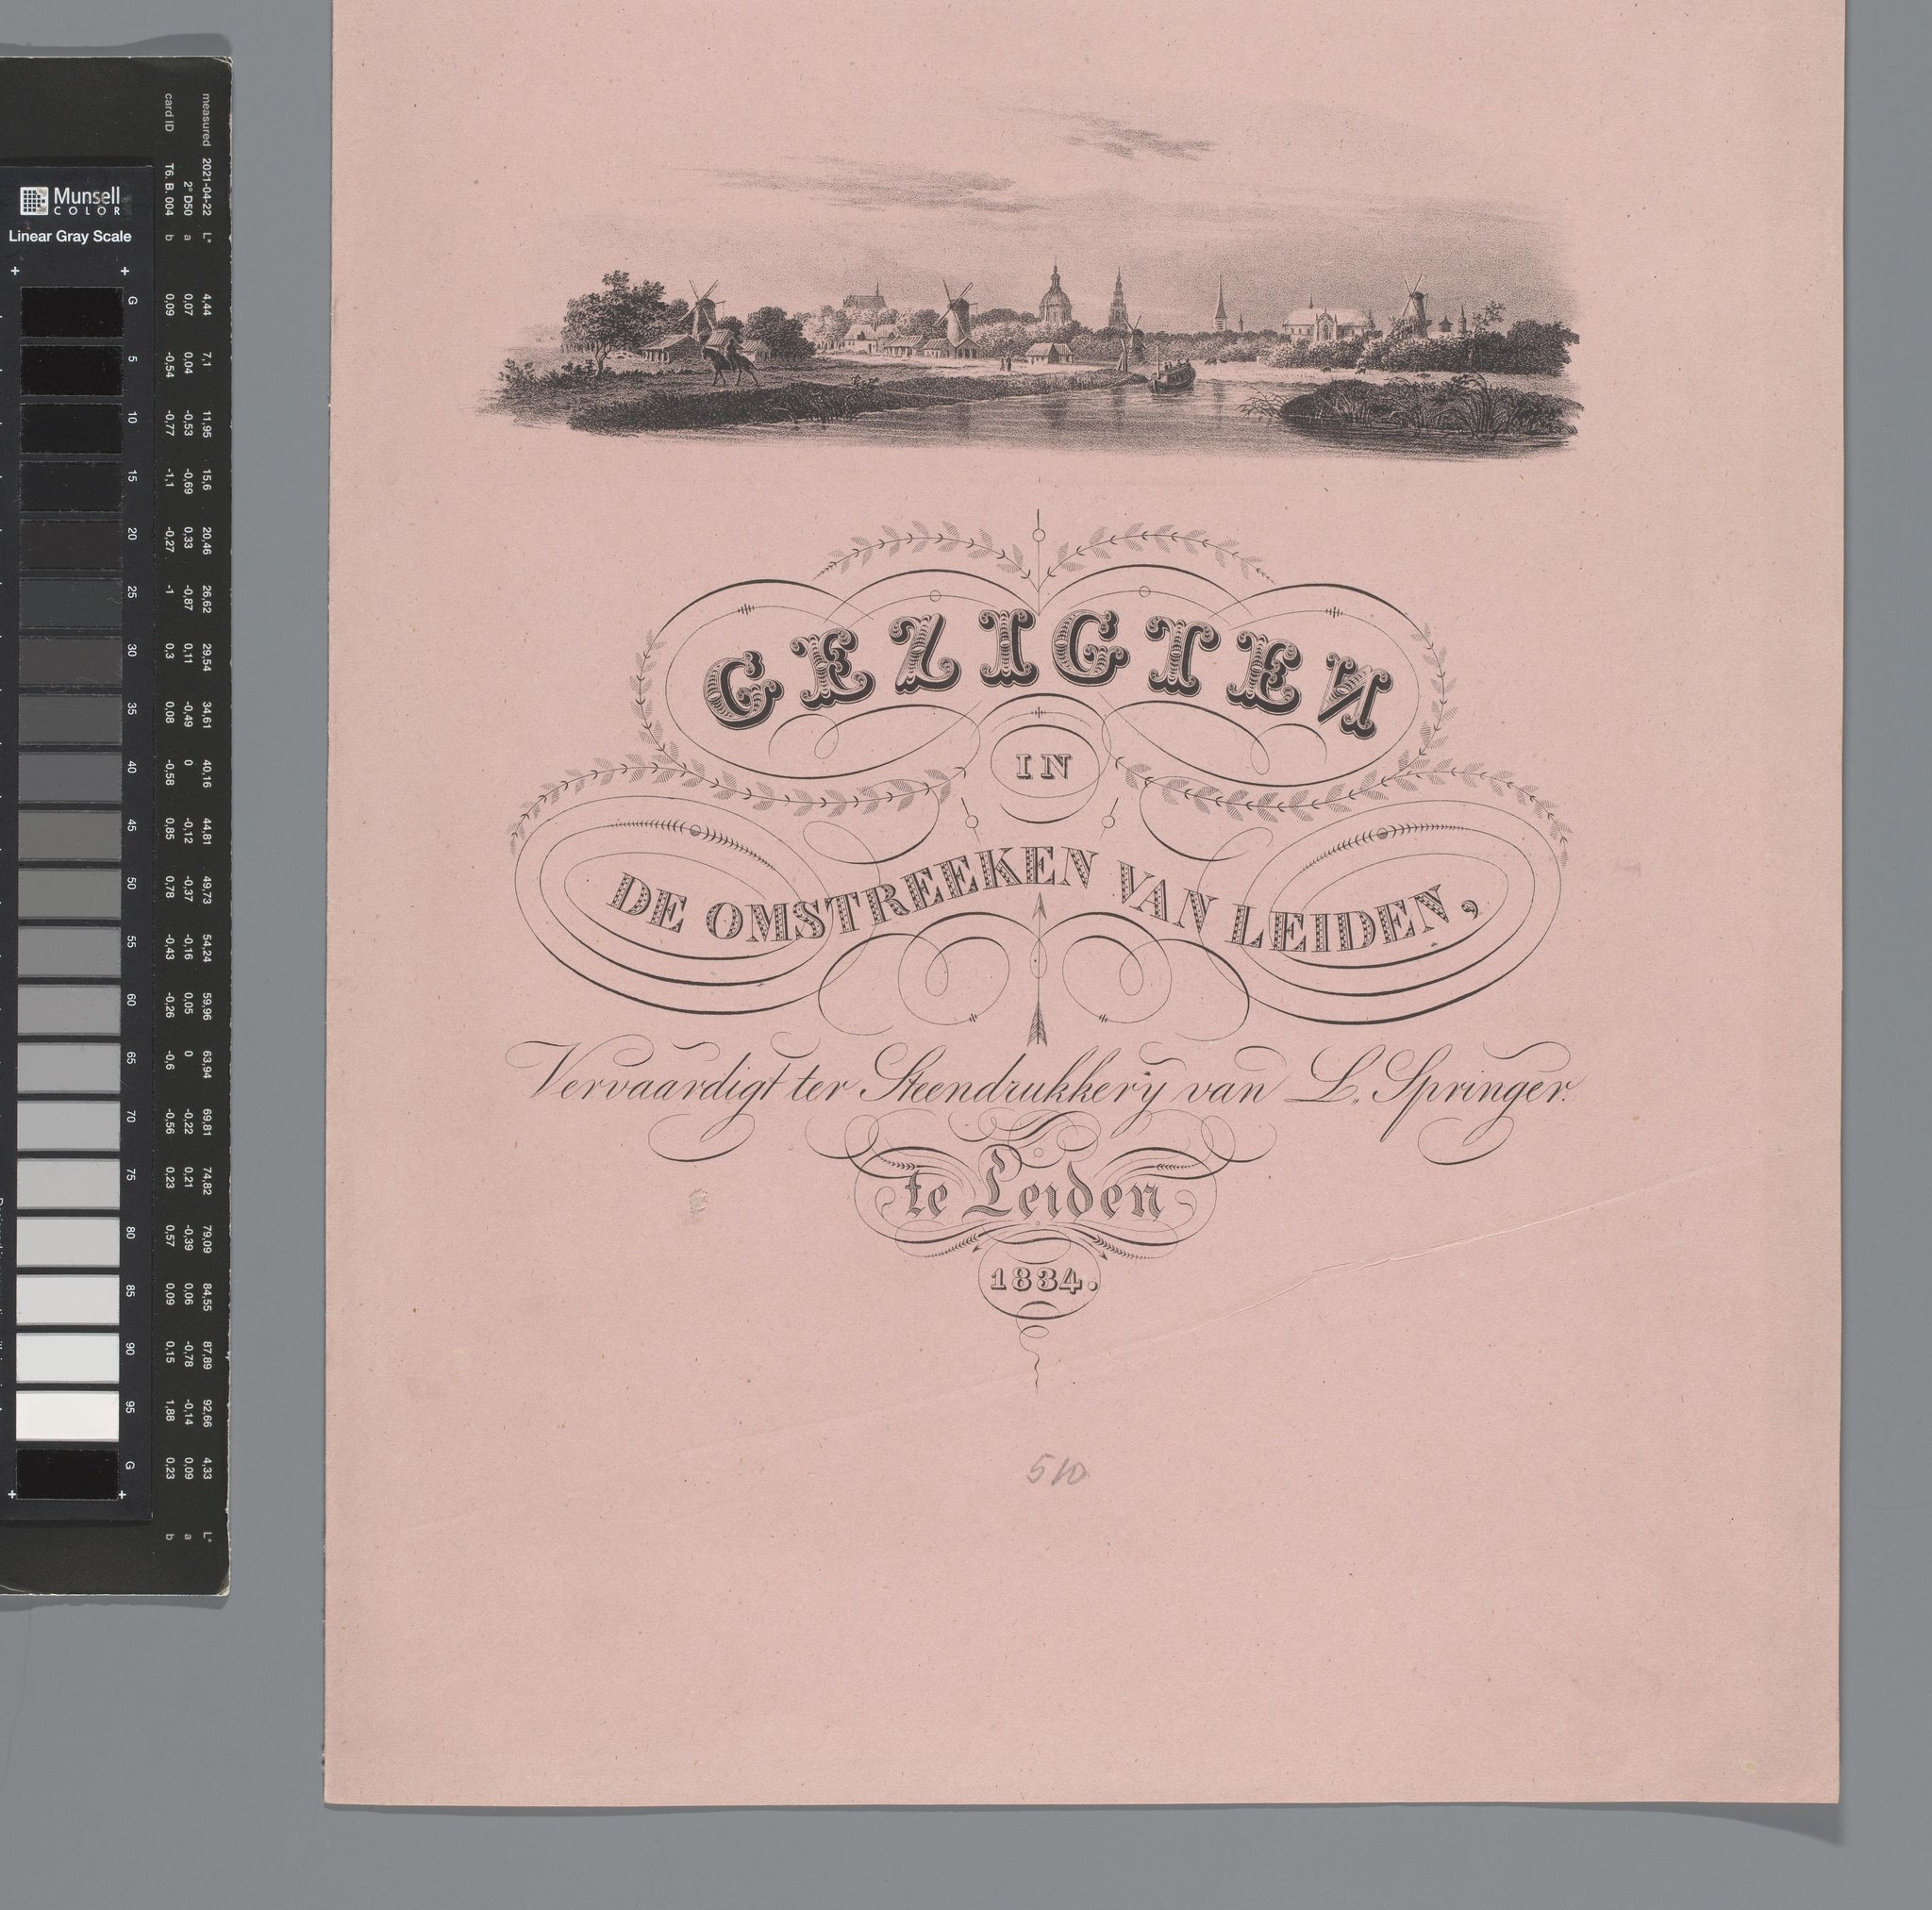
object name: print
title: Gezigten in de omstreeken van Leiden, vervaardigt ter steendrukkerij van L. Springer te Leiden 1834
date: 1834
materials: paper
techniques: lithograph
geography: netherlands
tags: traffic on the water (+ propulsion of vehicle, ship, etc. by animals), tow-boat, towing-barge, river (+ landscape with figures, staffage), leiden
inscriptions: date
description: Bovenin een rivierlandschap met een trekschuit. Lege omslag.